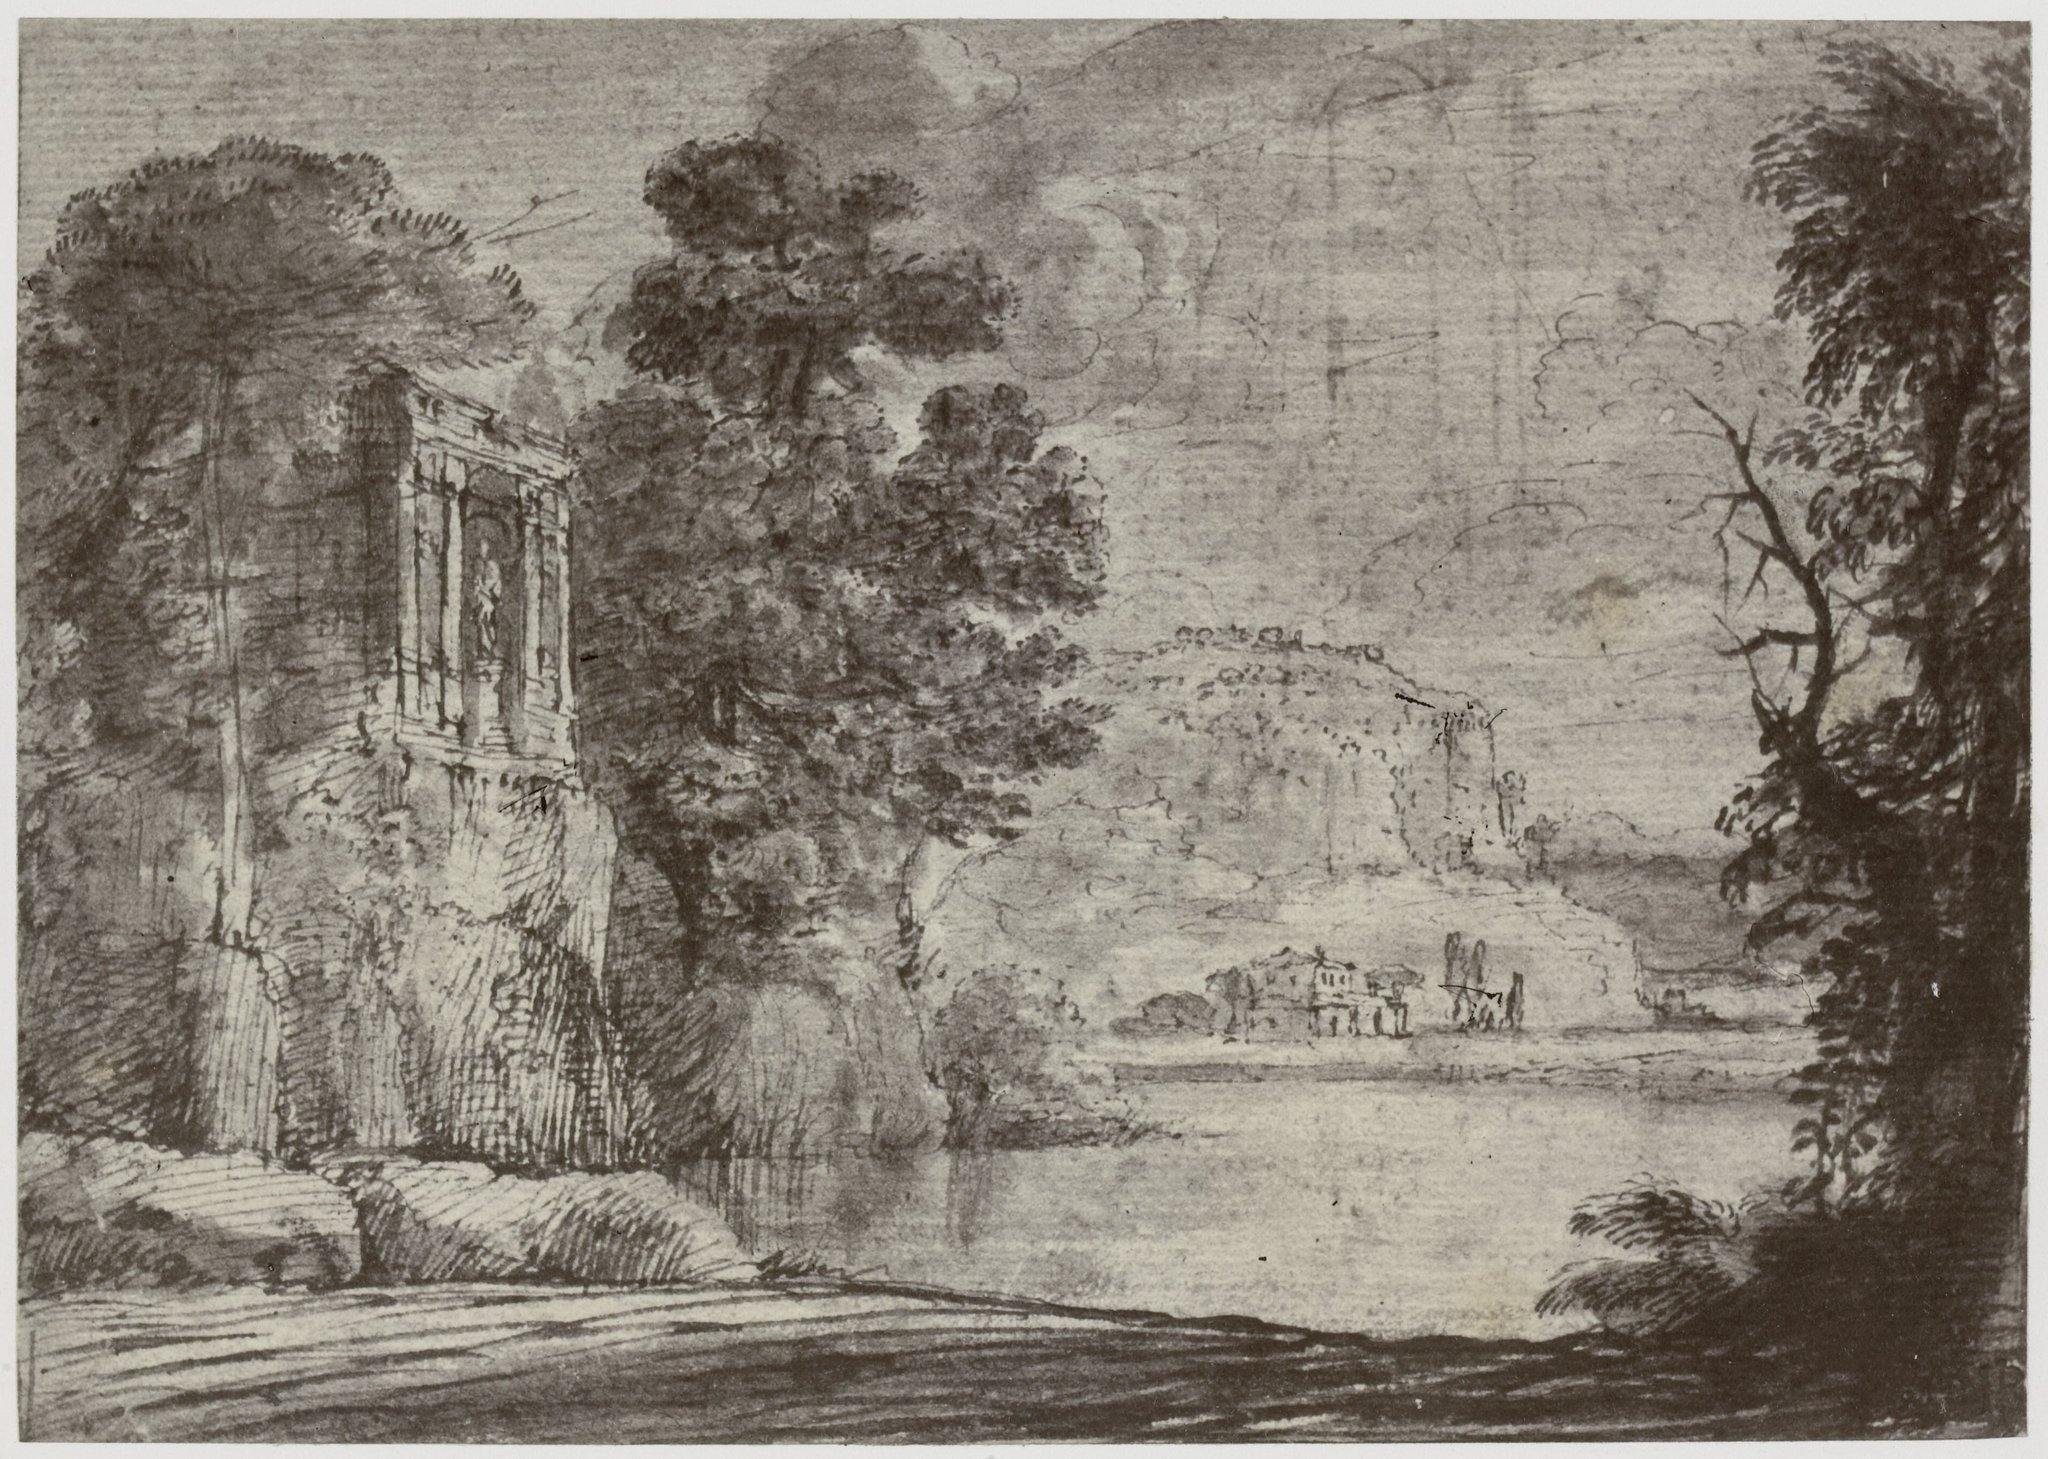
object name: photograph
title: Claude [Lorrain], Evening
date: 1855-1858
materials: cardboard, paper, photographic support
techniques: albumen print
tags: rome, print maker, draughtsman, claude lorrain, drawing, sketch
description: Fotoreproductie van tekening in 'The Reveley Collection of Drawings at Brynygwin', afb. 36.